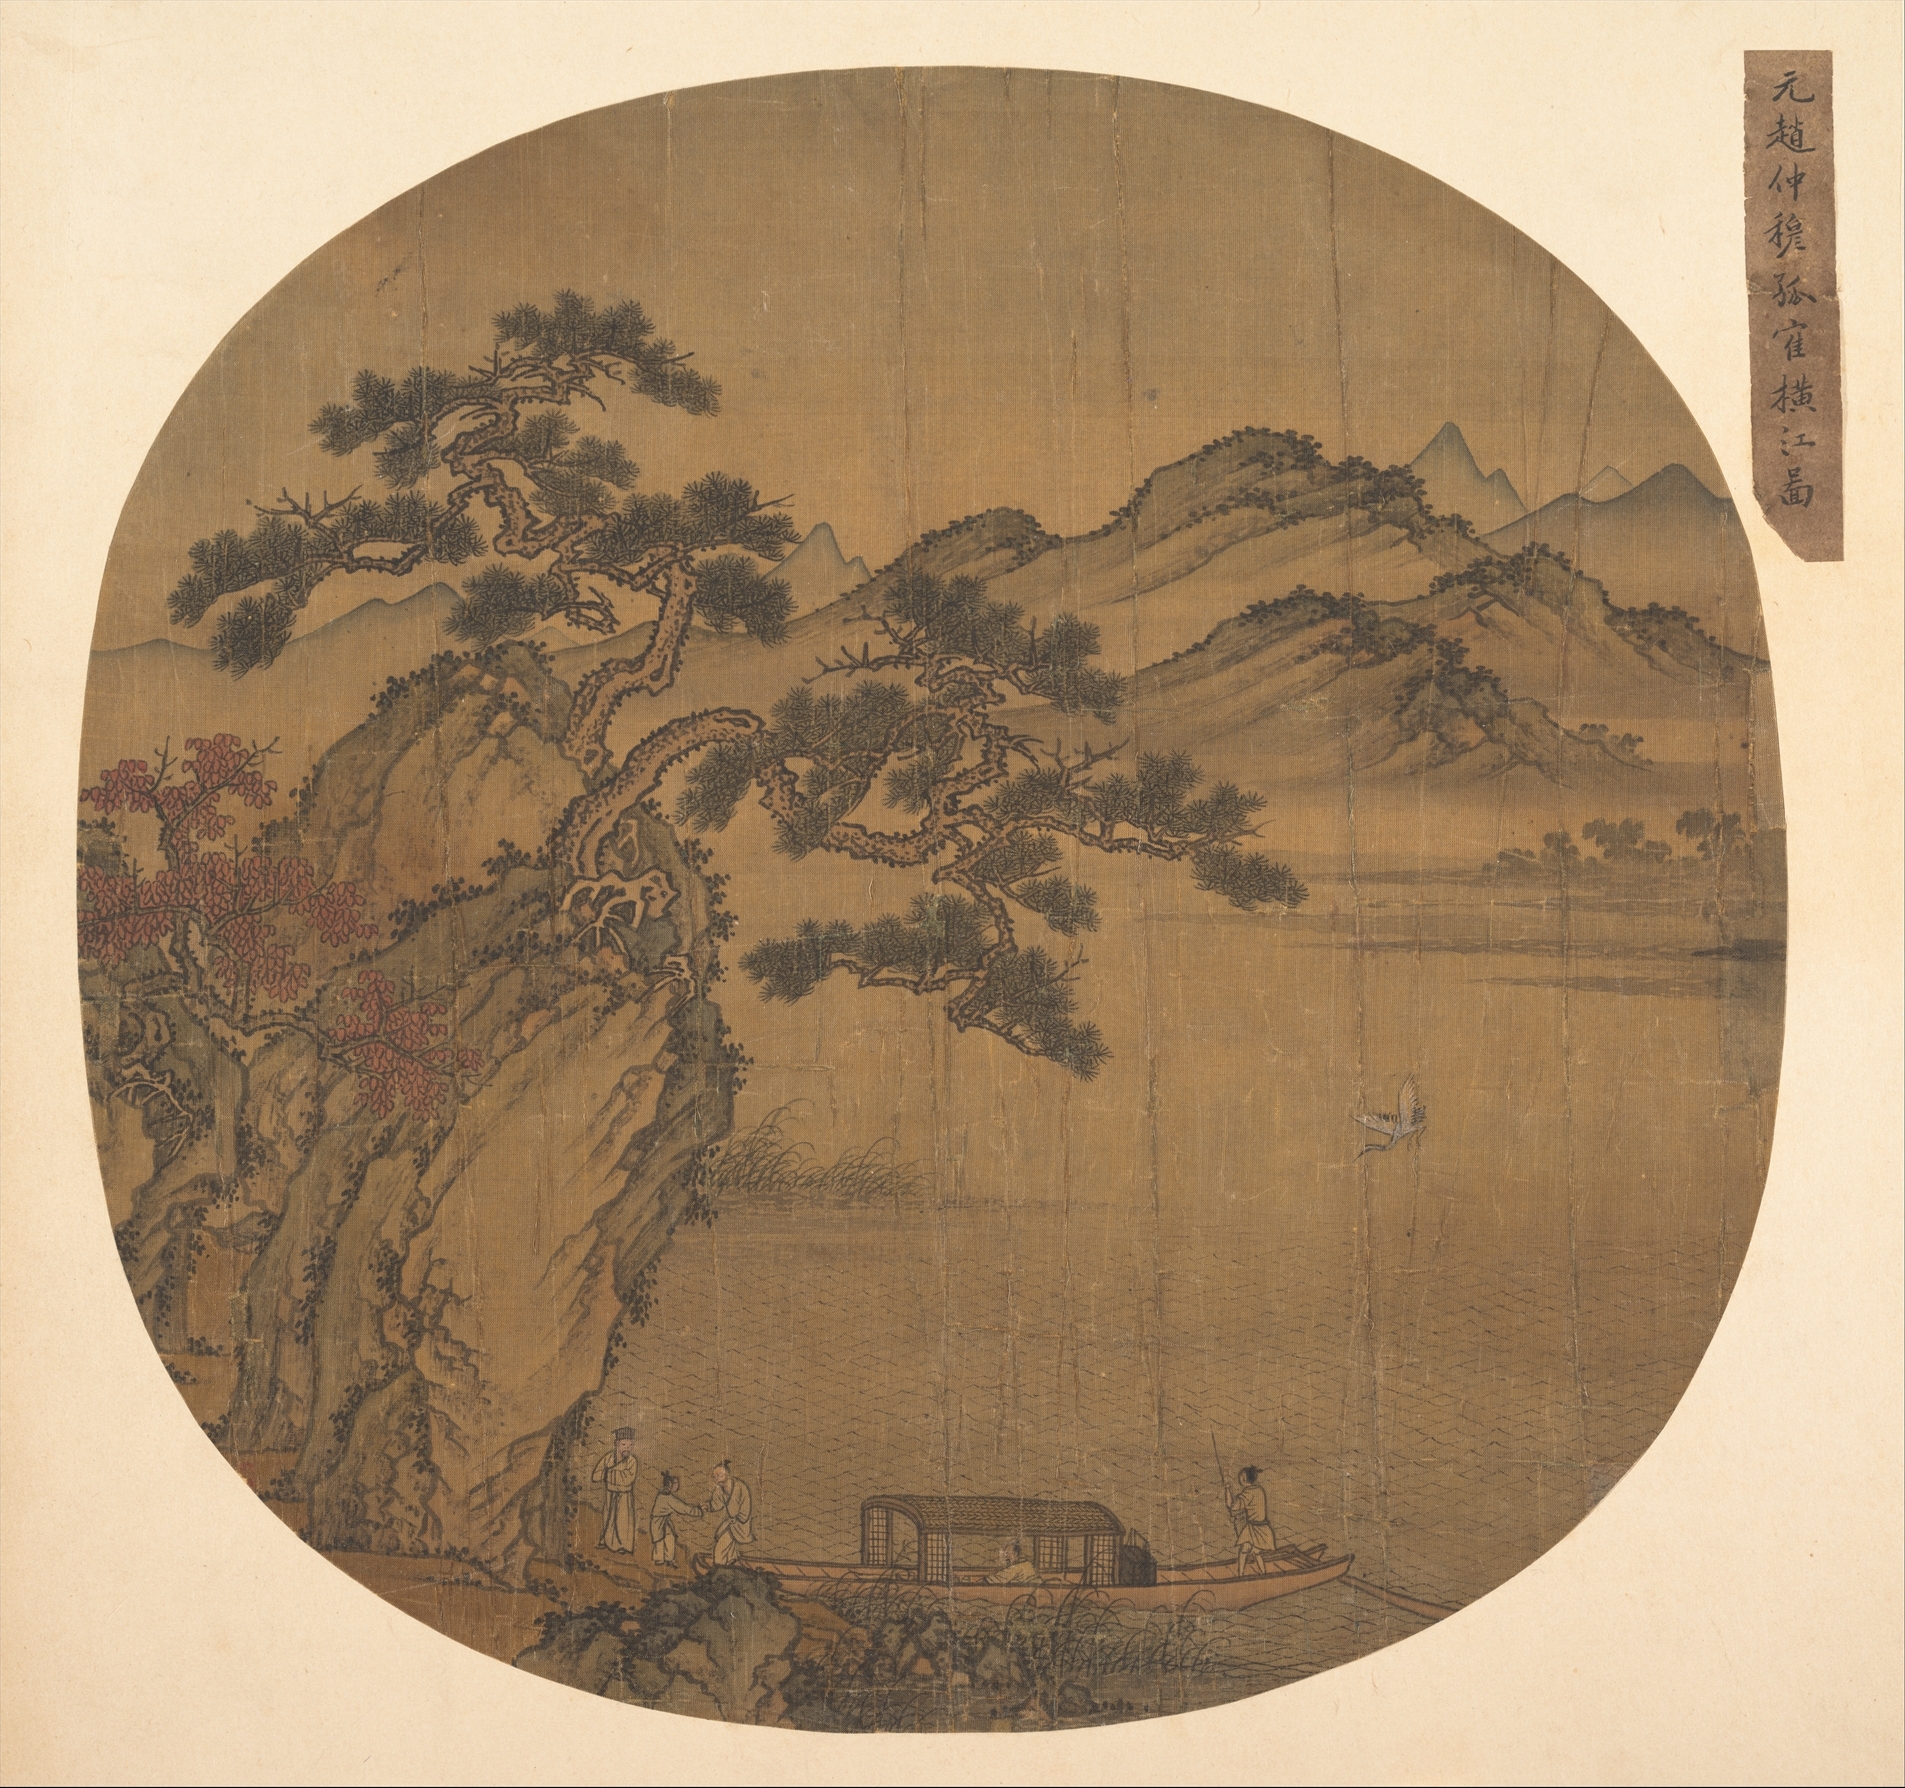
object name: fan mounted a an album leaf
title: Illustration of Su Shi’s “Second Rhapsody on Red Cliff”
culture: chinese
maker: unidentified artist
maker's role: artist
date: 1367-1433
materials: ink, silk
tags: mountains,landscapes,trees,boats